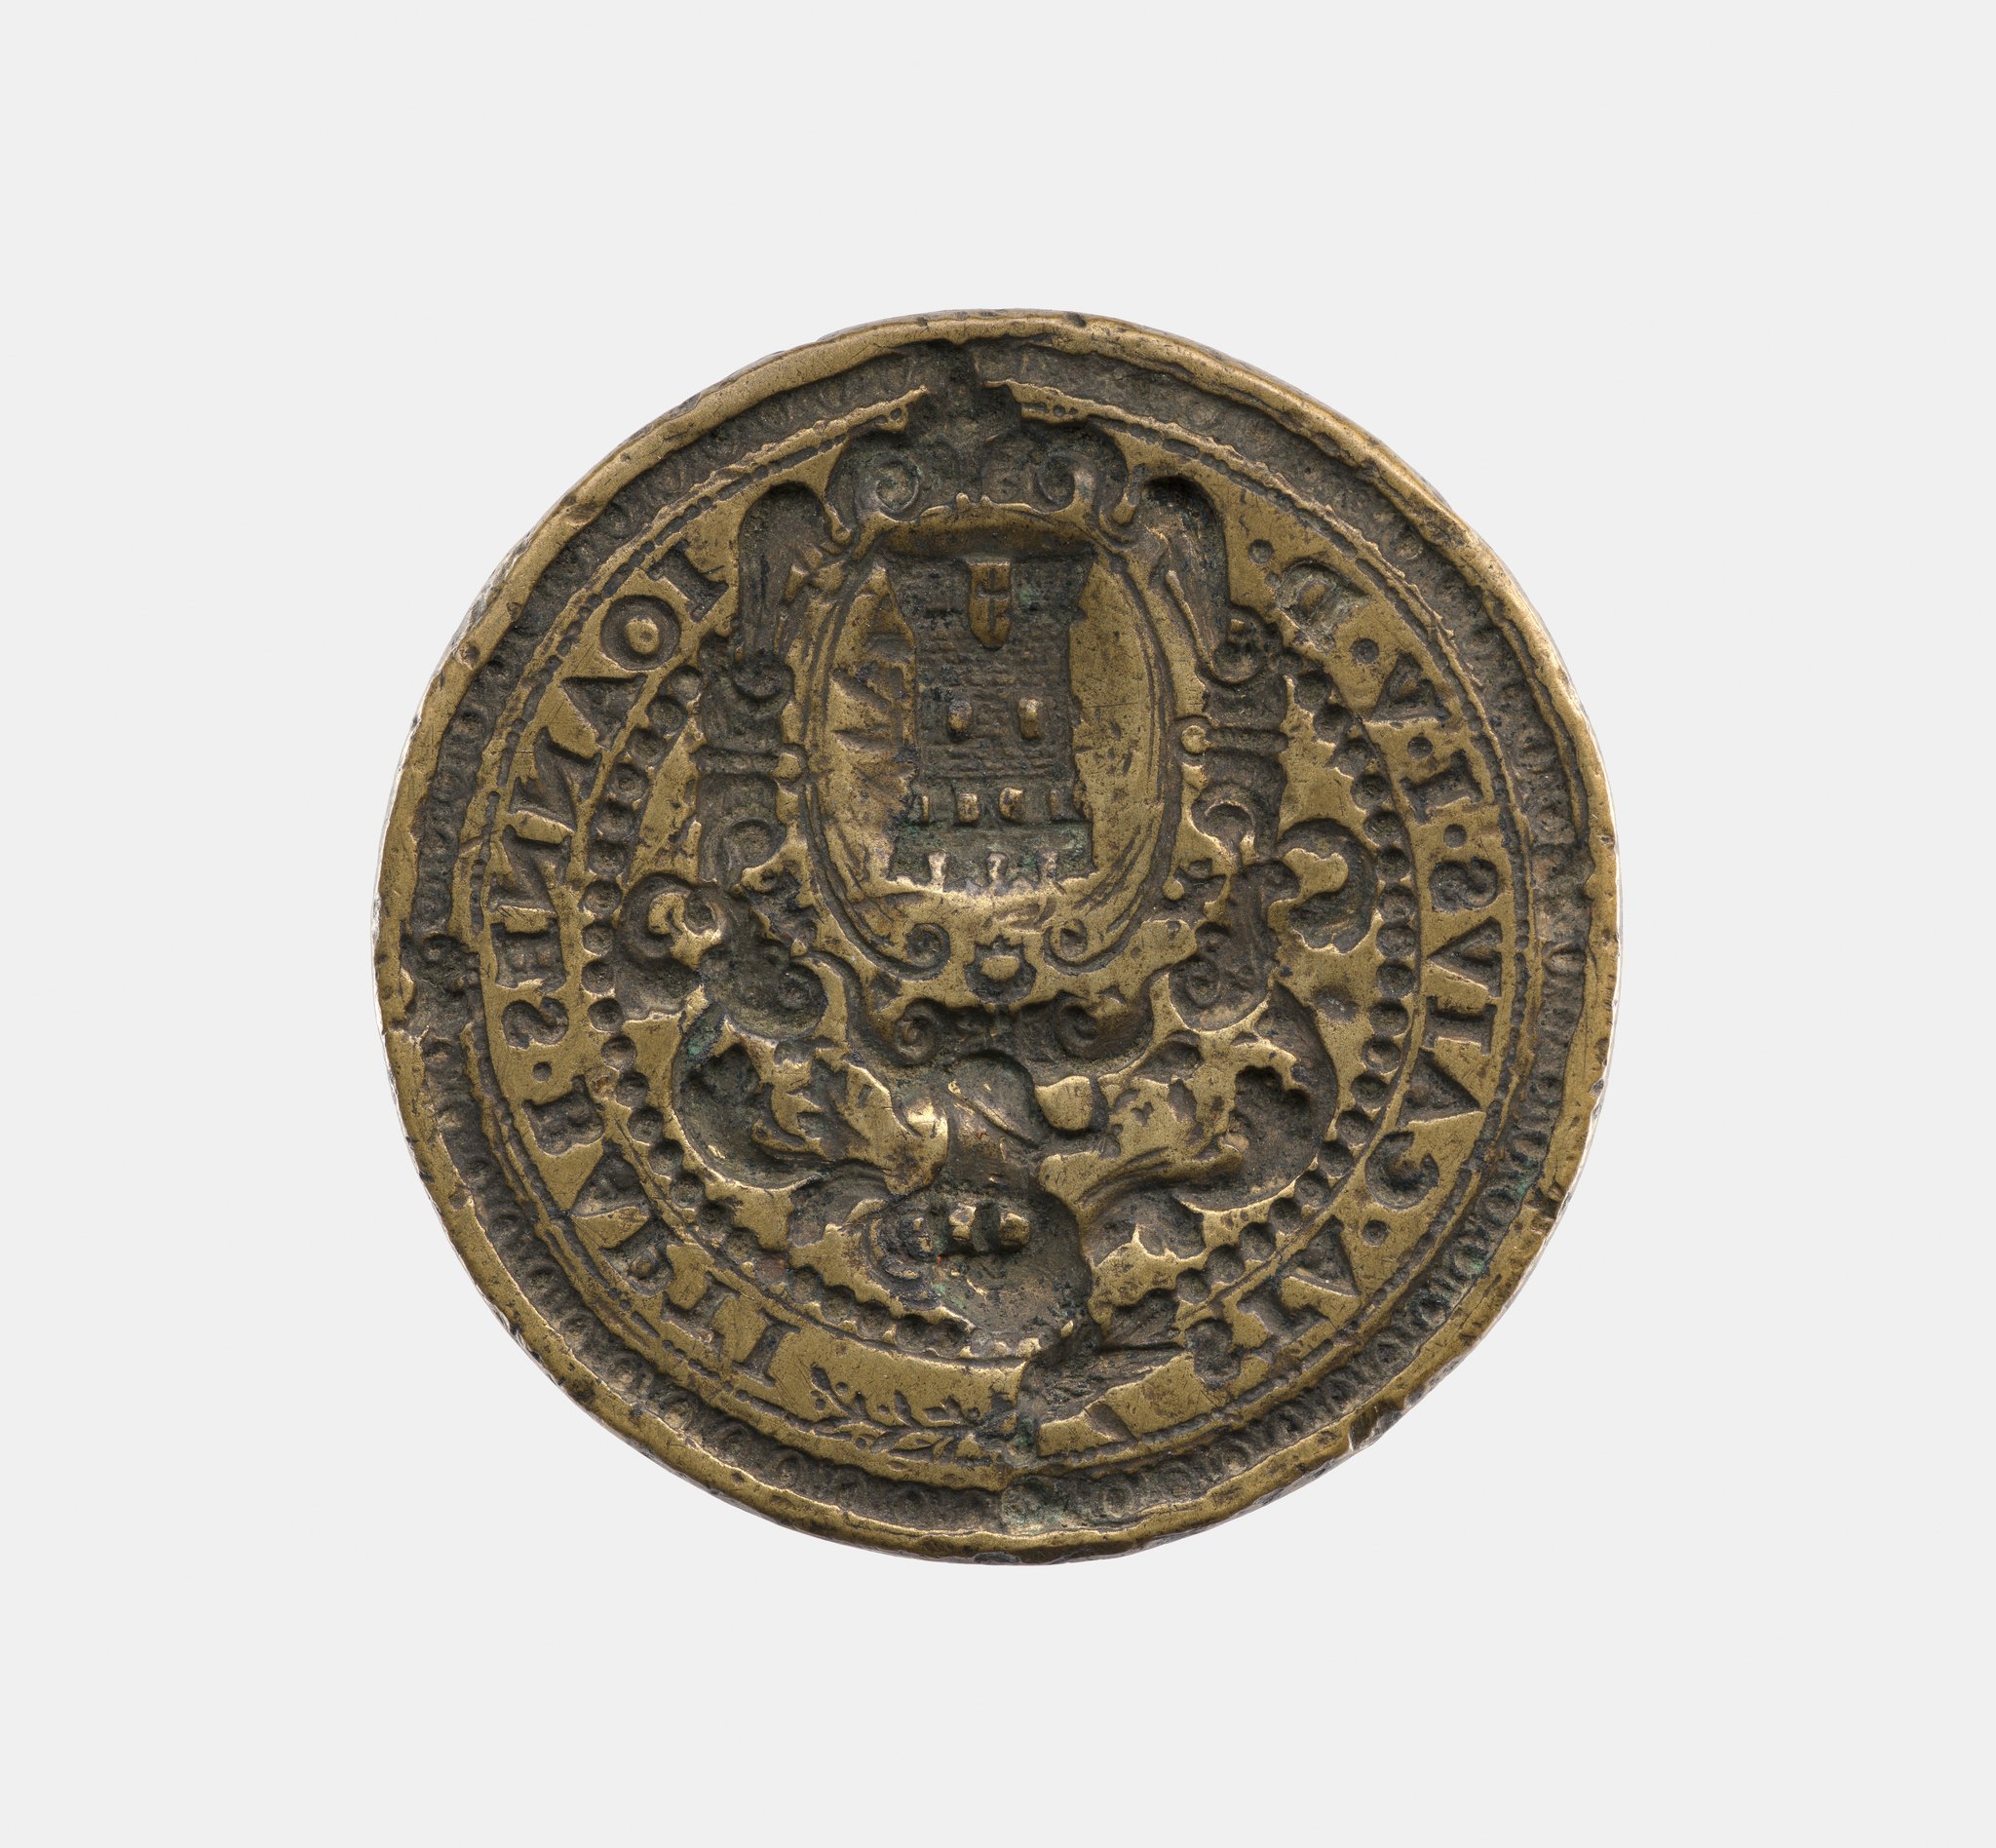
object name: stamp seal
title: John Baptist Caius (1510–1573)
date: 1543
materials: bronze